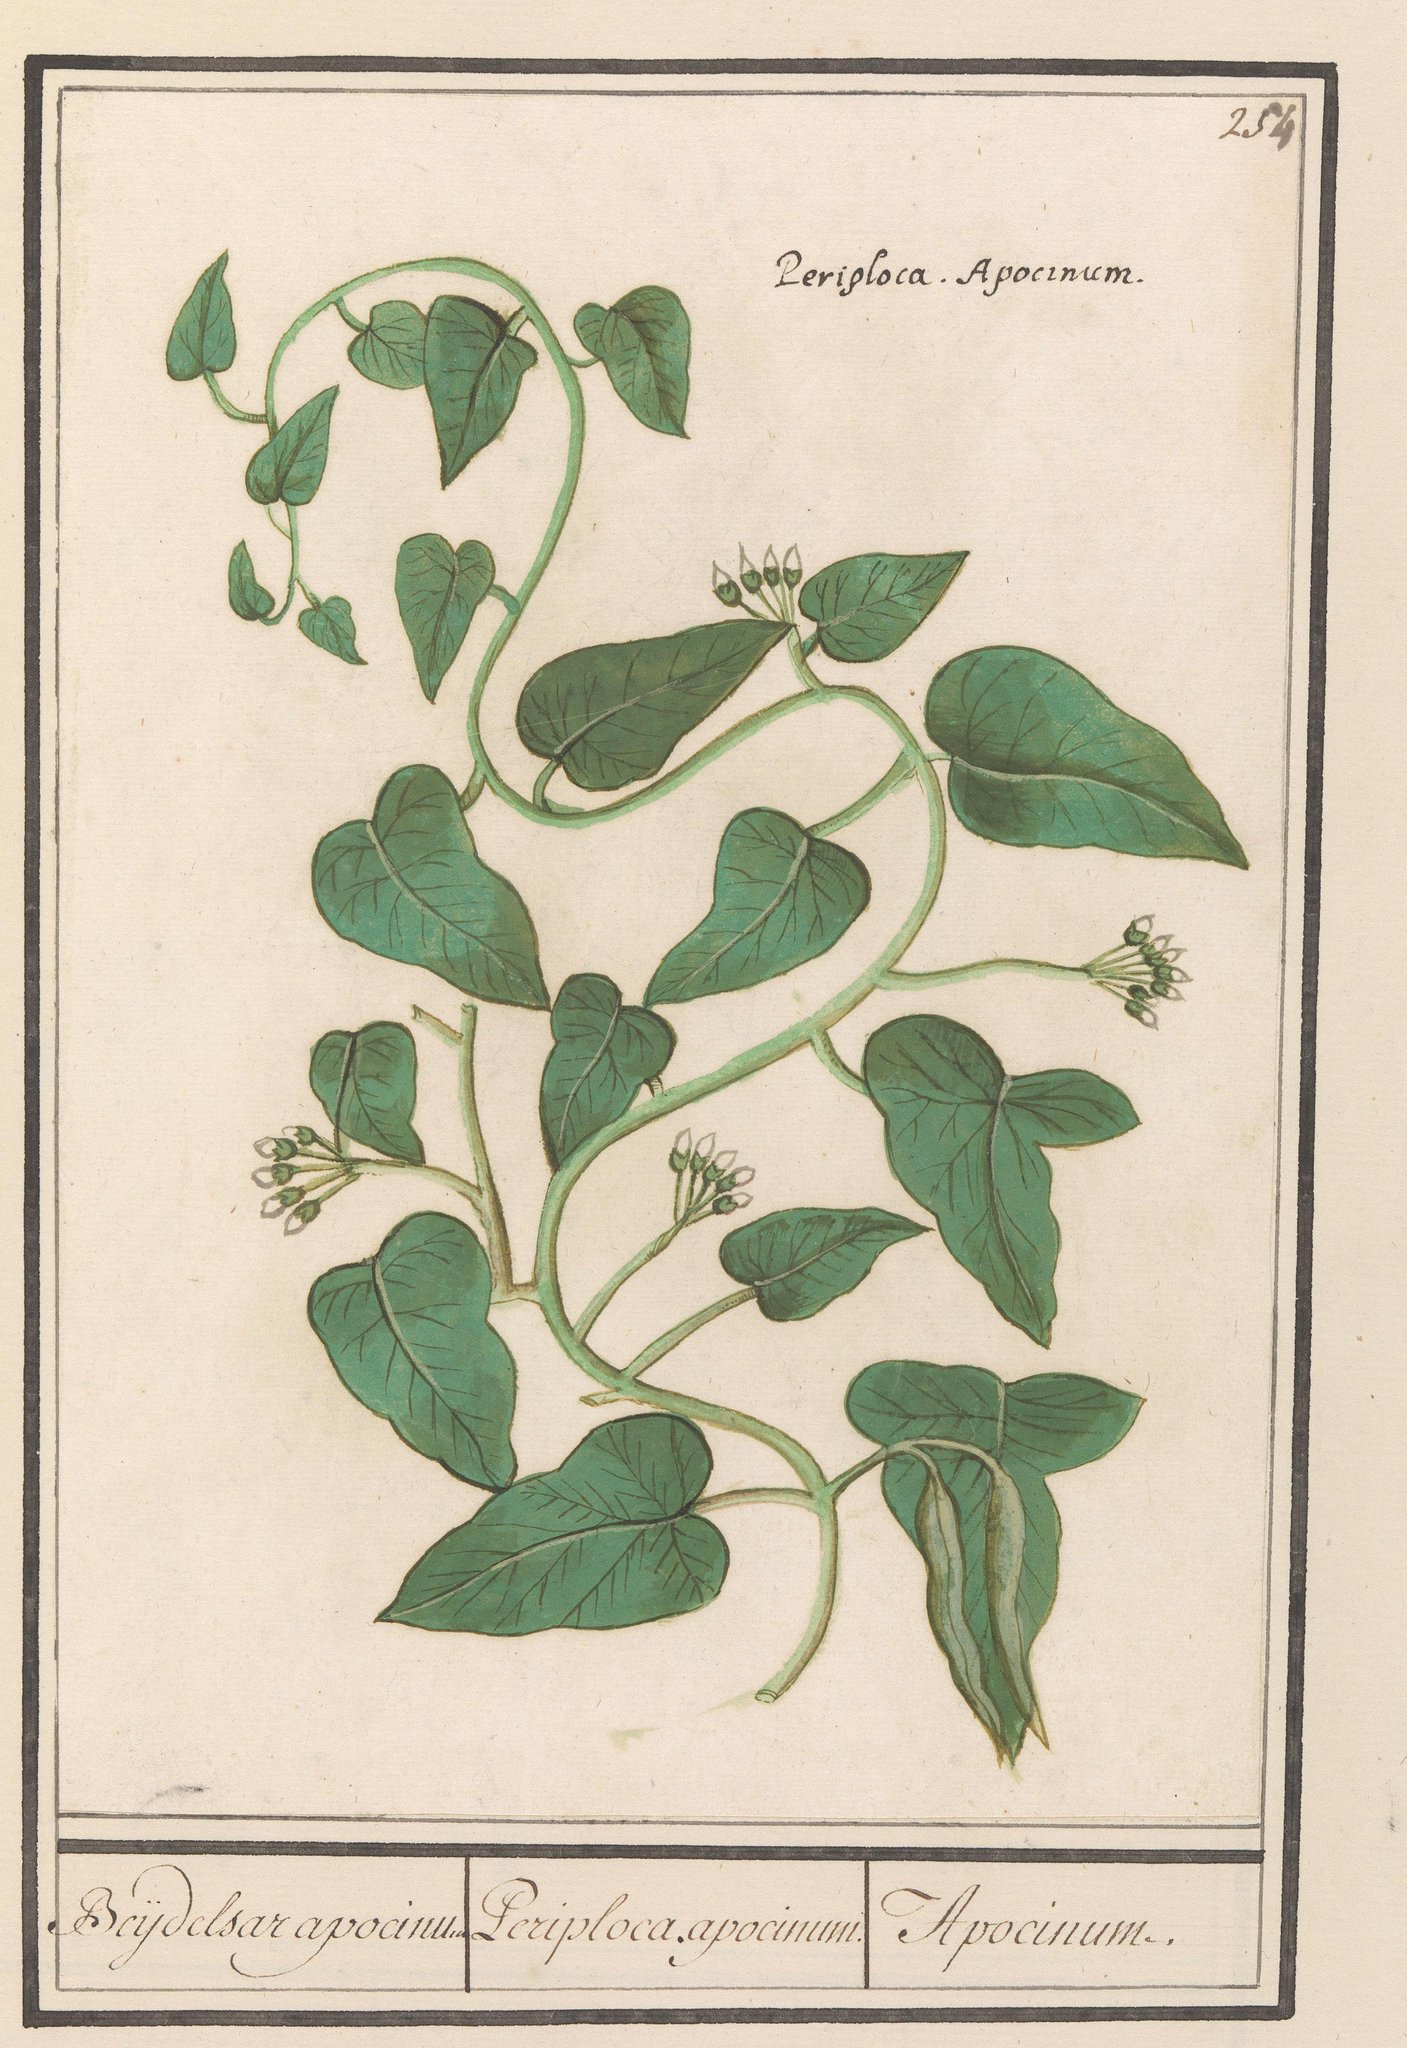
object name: drawing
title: Apocynum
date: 1596-1610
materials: chalk, paint, ink, paper, watercolor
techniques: brush, pen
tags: plants and herbs: dogbane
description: Apocynum. Genummerd rechtsboven: 254. Met de Latijnse naam. Onderdeel van het derde album met tekeningen van bloemen en planten. Tiende van twaalf albums met tekeningen van dieren, vogels en planten bekend rond 1600, gemaakt in opdracht van keizer Rudolf II. Met toelichting in Nederlands, Latijn en Frans.